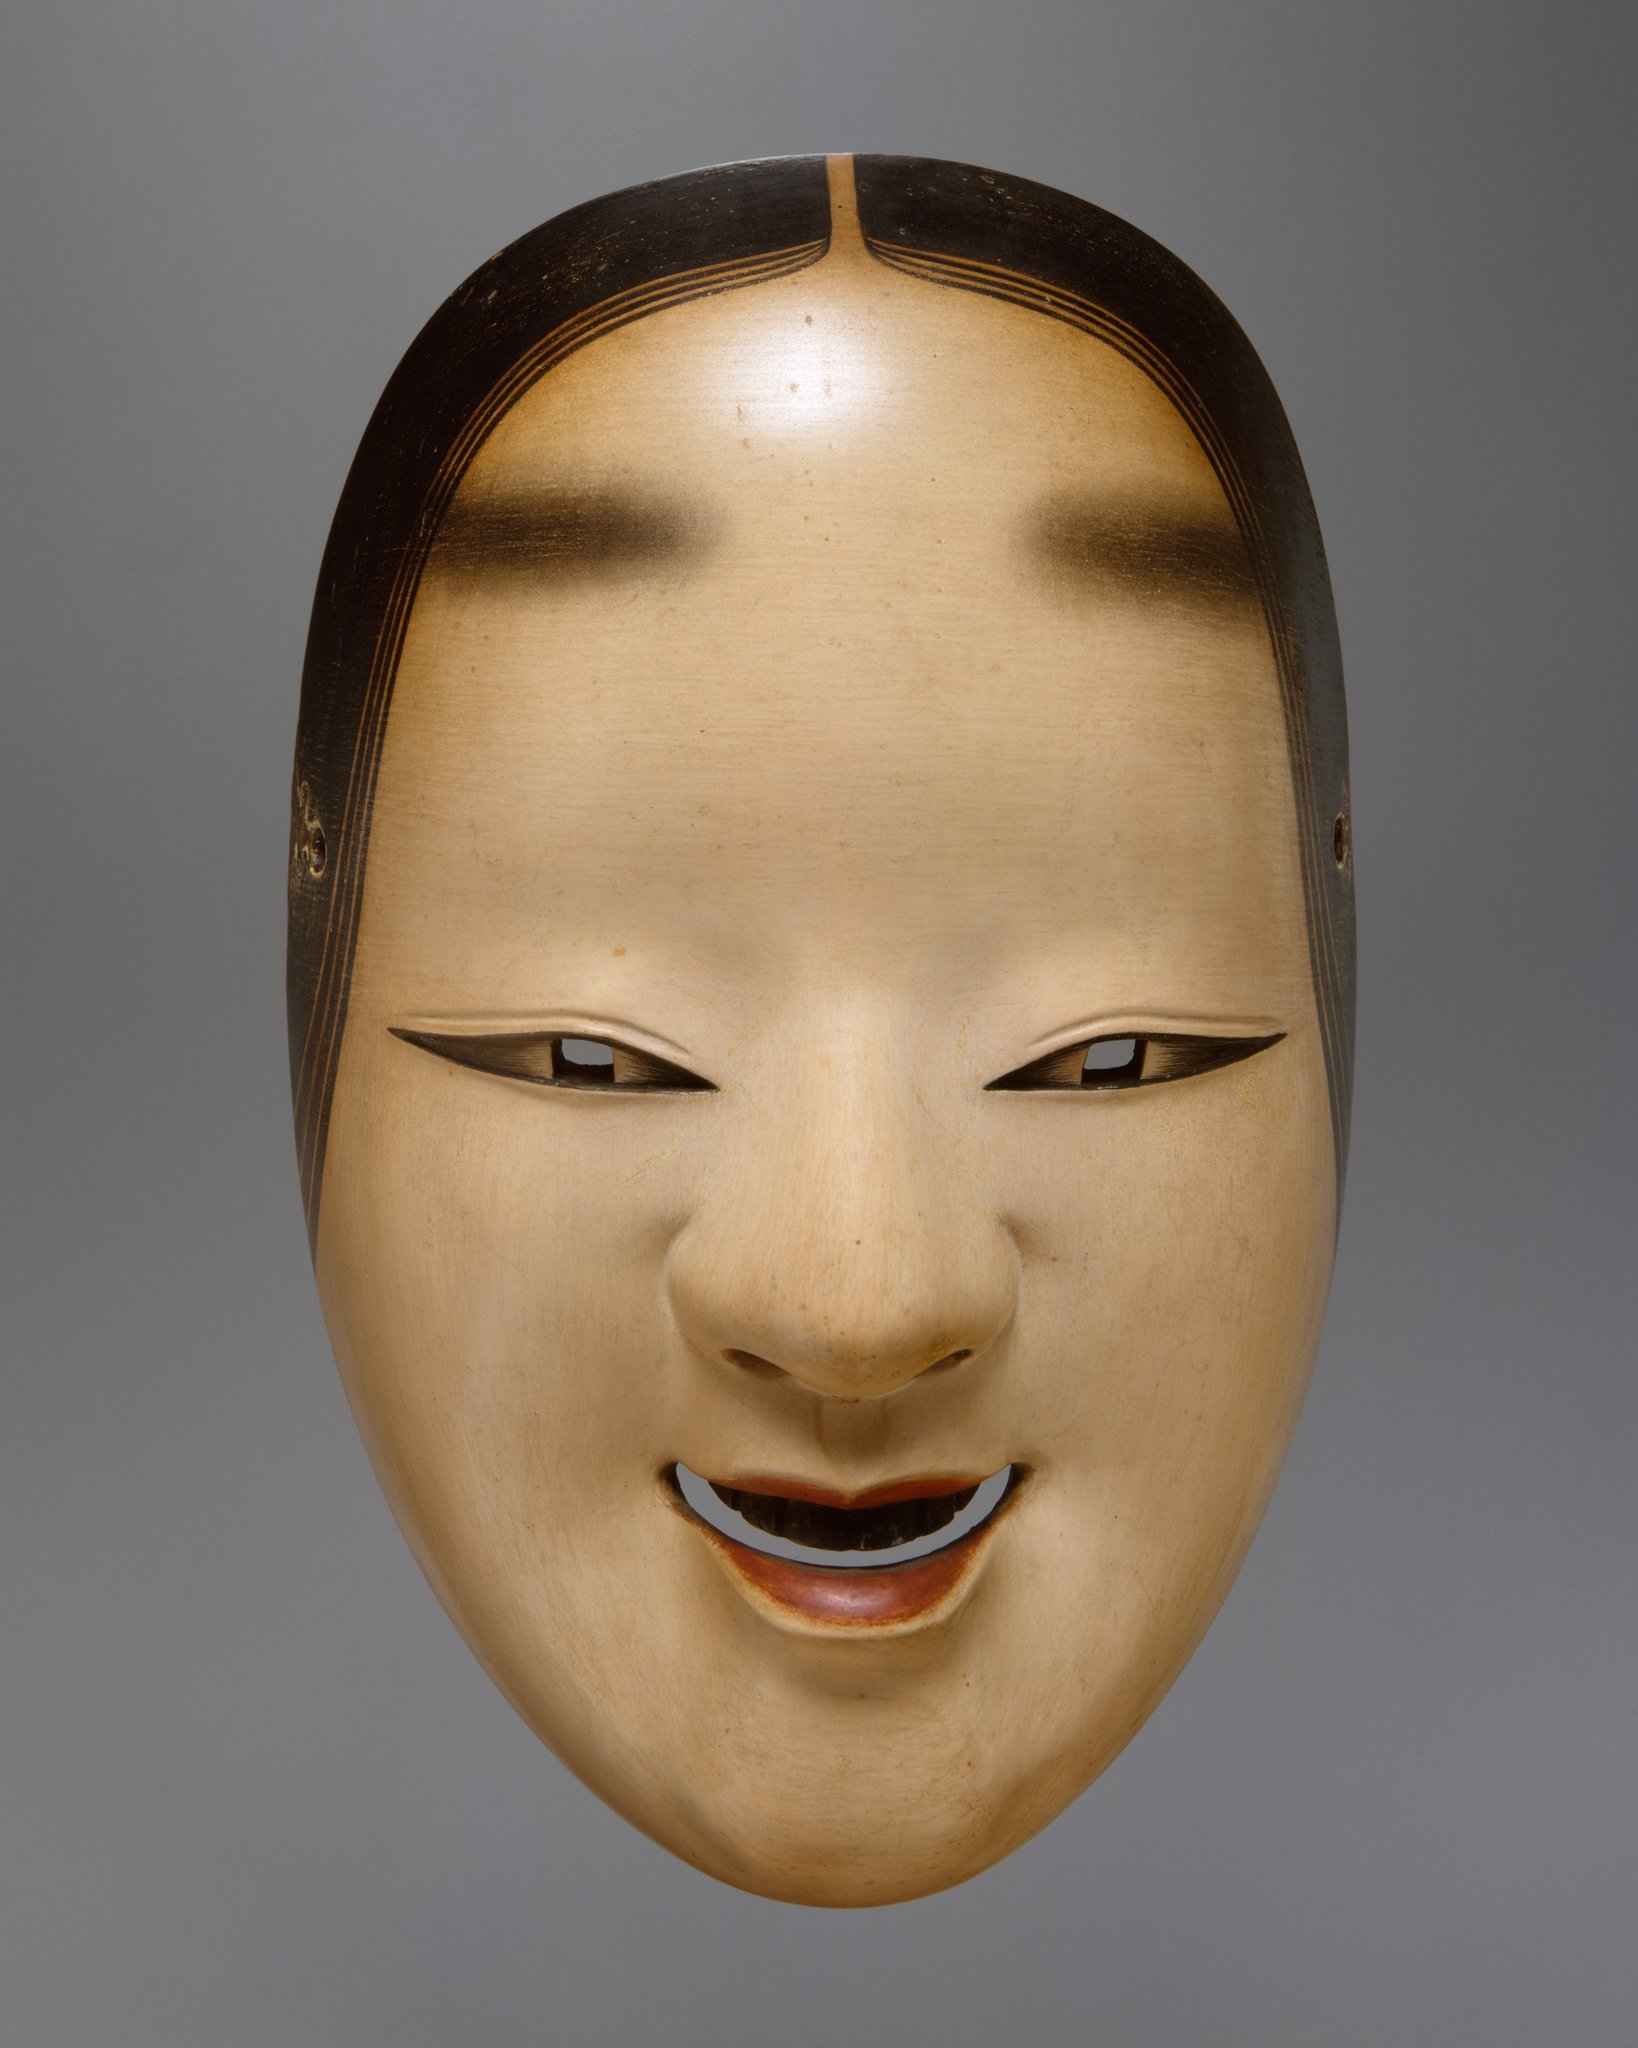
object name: noh mask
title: Ko-omote Noh Mask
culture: japanese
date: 1701-1800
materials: wood, pigment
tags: masks